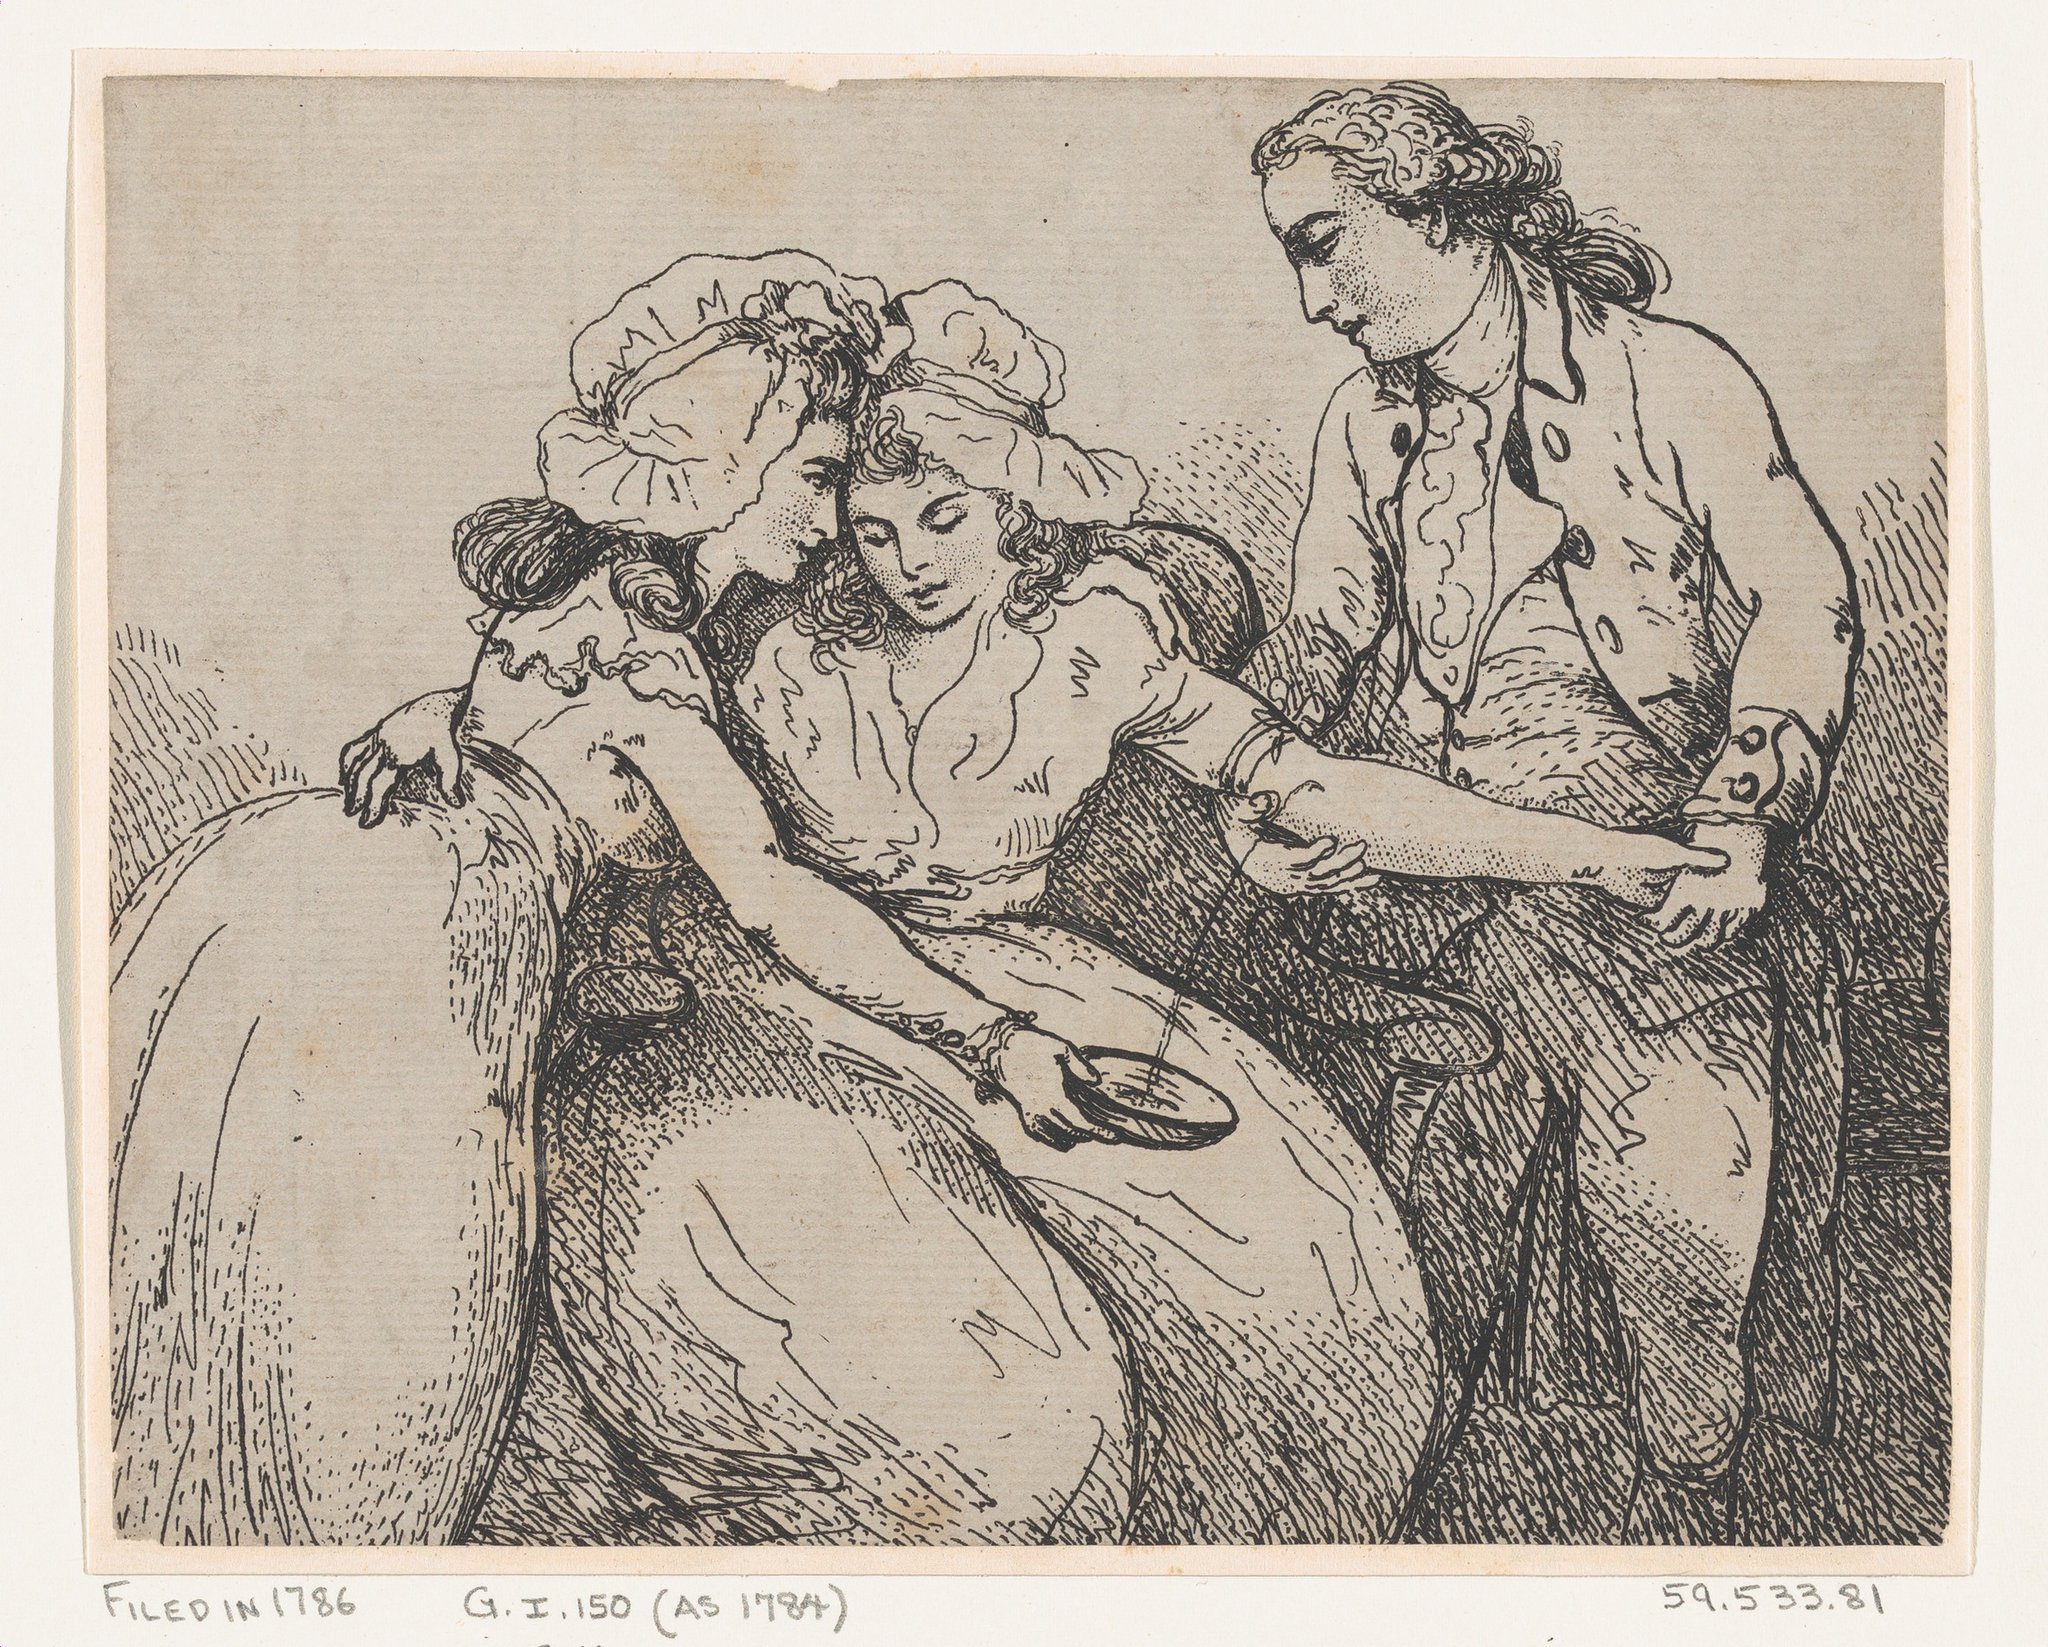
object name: print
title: Opening a Vein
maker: thomas rowlandson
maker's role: artist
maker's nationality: british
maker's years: 1757-1827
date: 1784-1786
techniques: etching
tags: illness,men,women